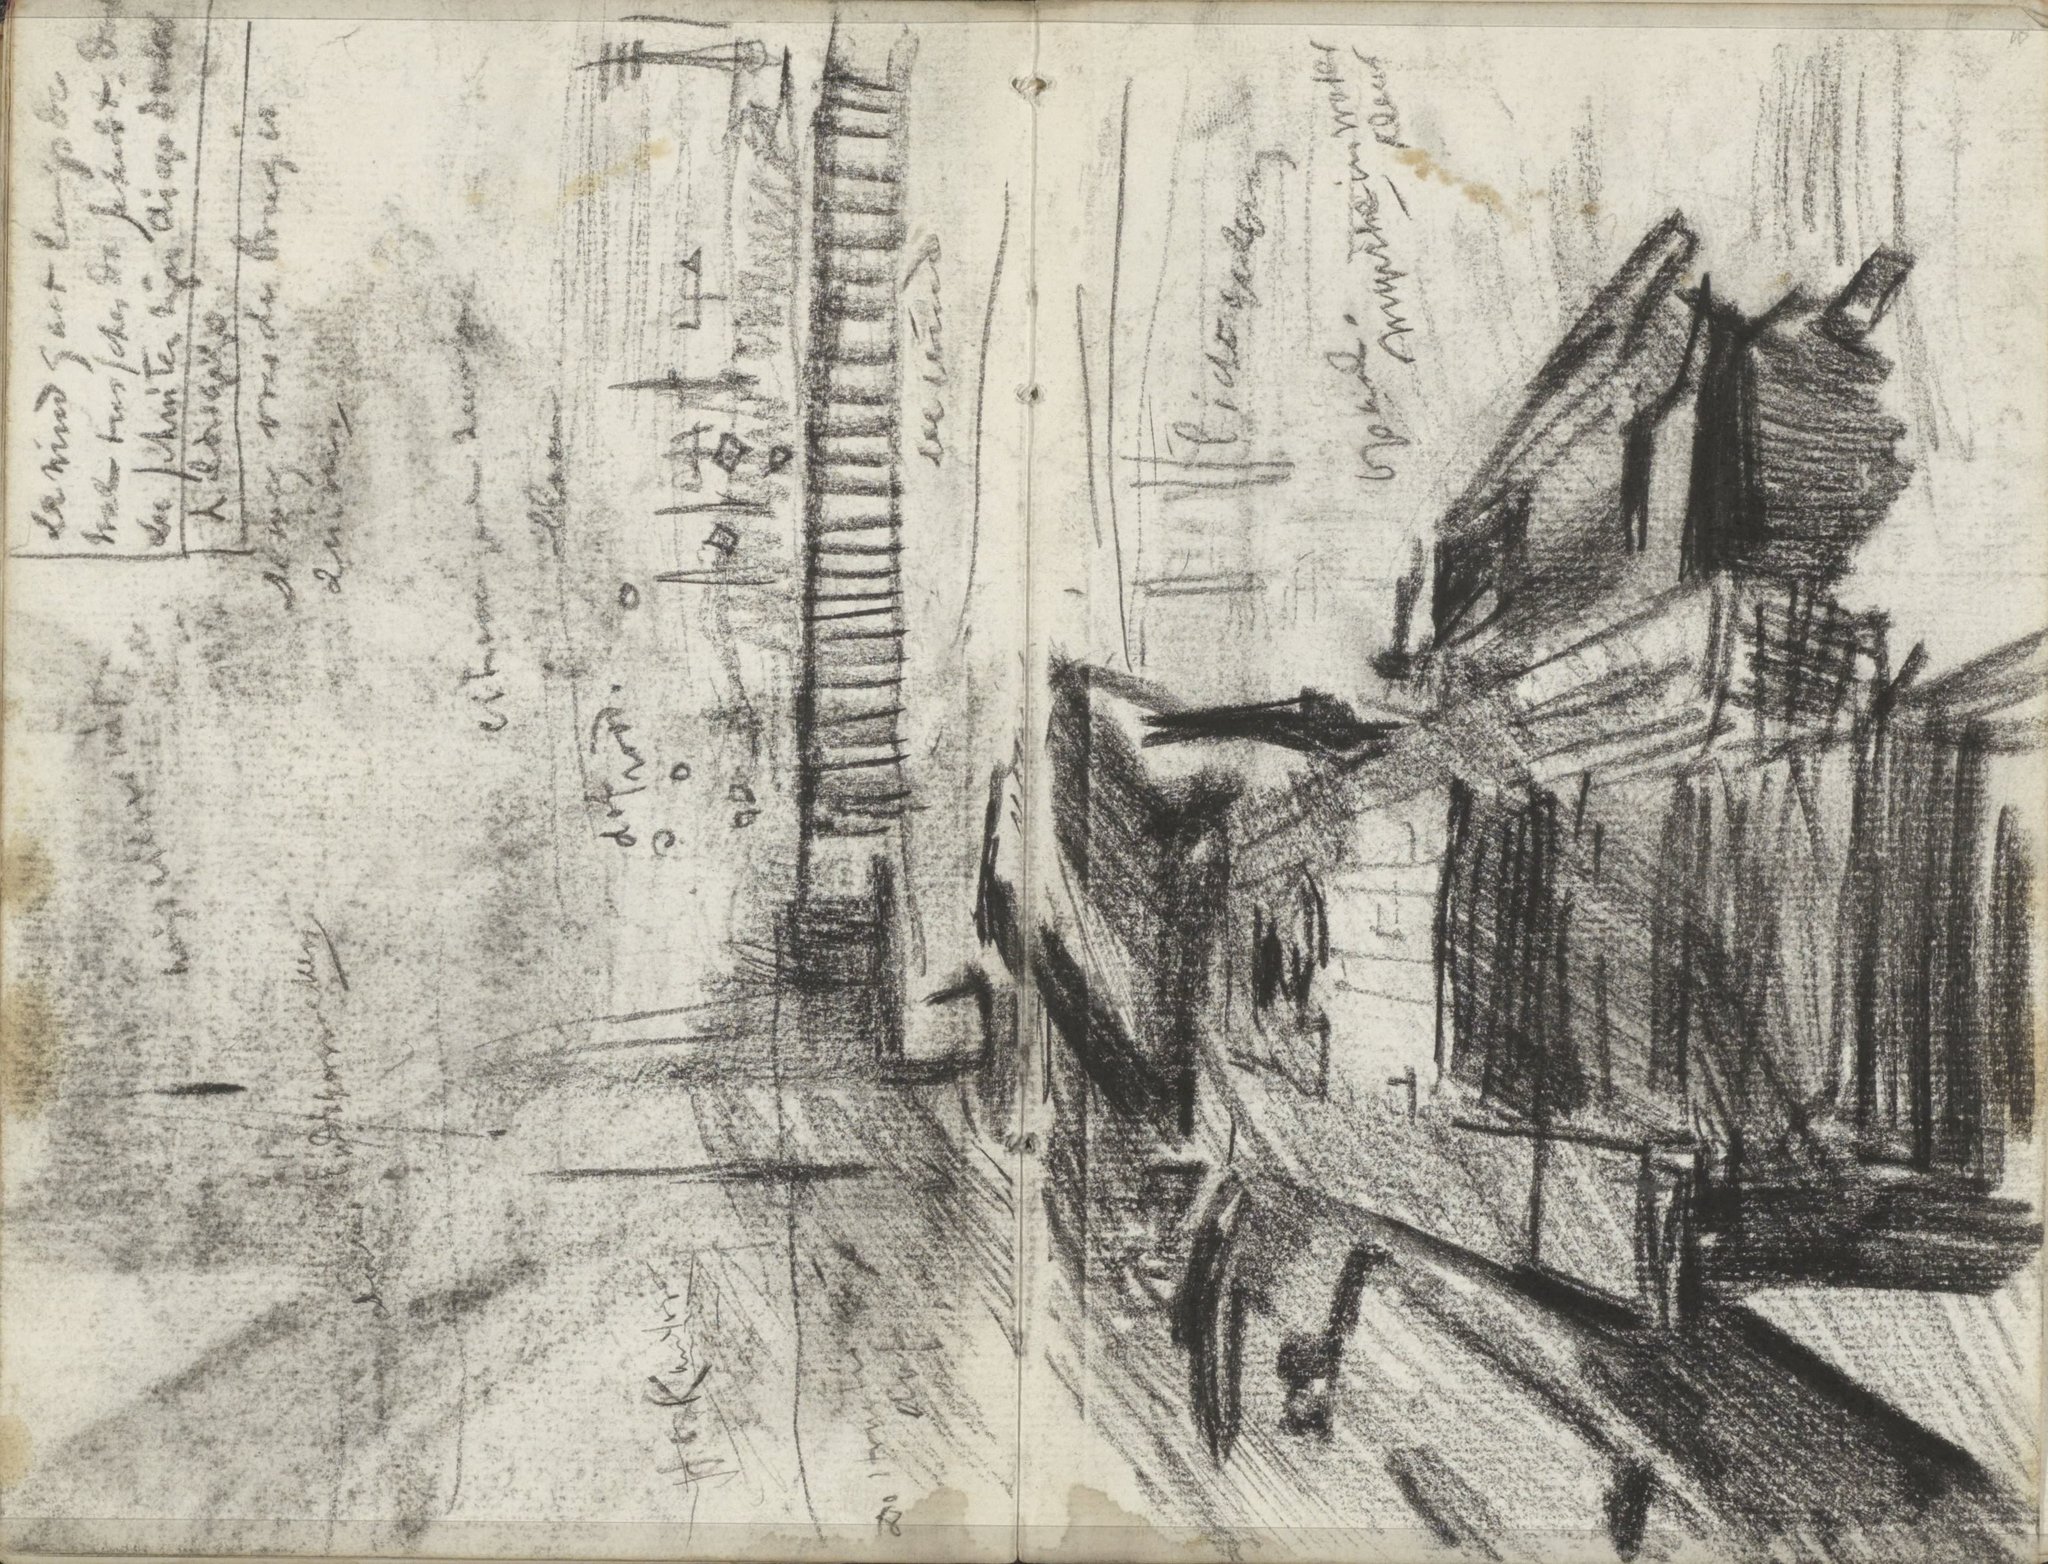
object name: sketchbook leaf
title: Aangemeerde schuiten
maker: george hendrik breitner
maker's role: draughtsman, painter, print maker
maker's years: 1857-1923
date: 1886-1898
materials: chalk, paper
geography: amsterdam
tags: ships (in general), bridge in city across river, canal, etc.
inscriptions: annotation: ‘de wind gaat langs de/ wal tusschen de [...]/ [...] schuiten zijn diep donker/ [...]/ De weg over de brug is/ [...]’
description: In de verte een brug. Pagina 9 en pagina 10 uit een schetsboek met 21 bladen.